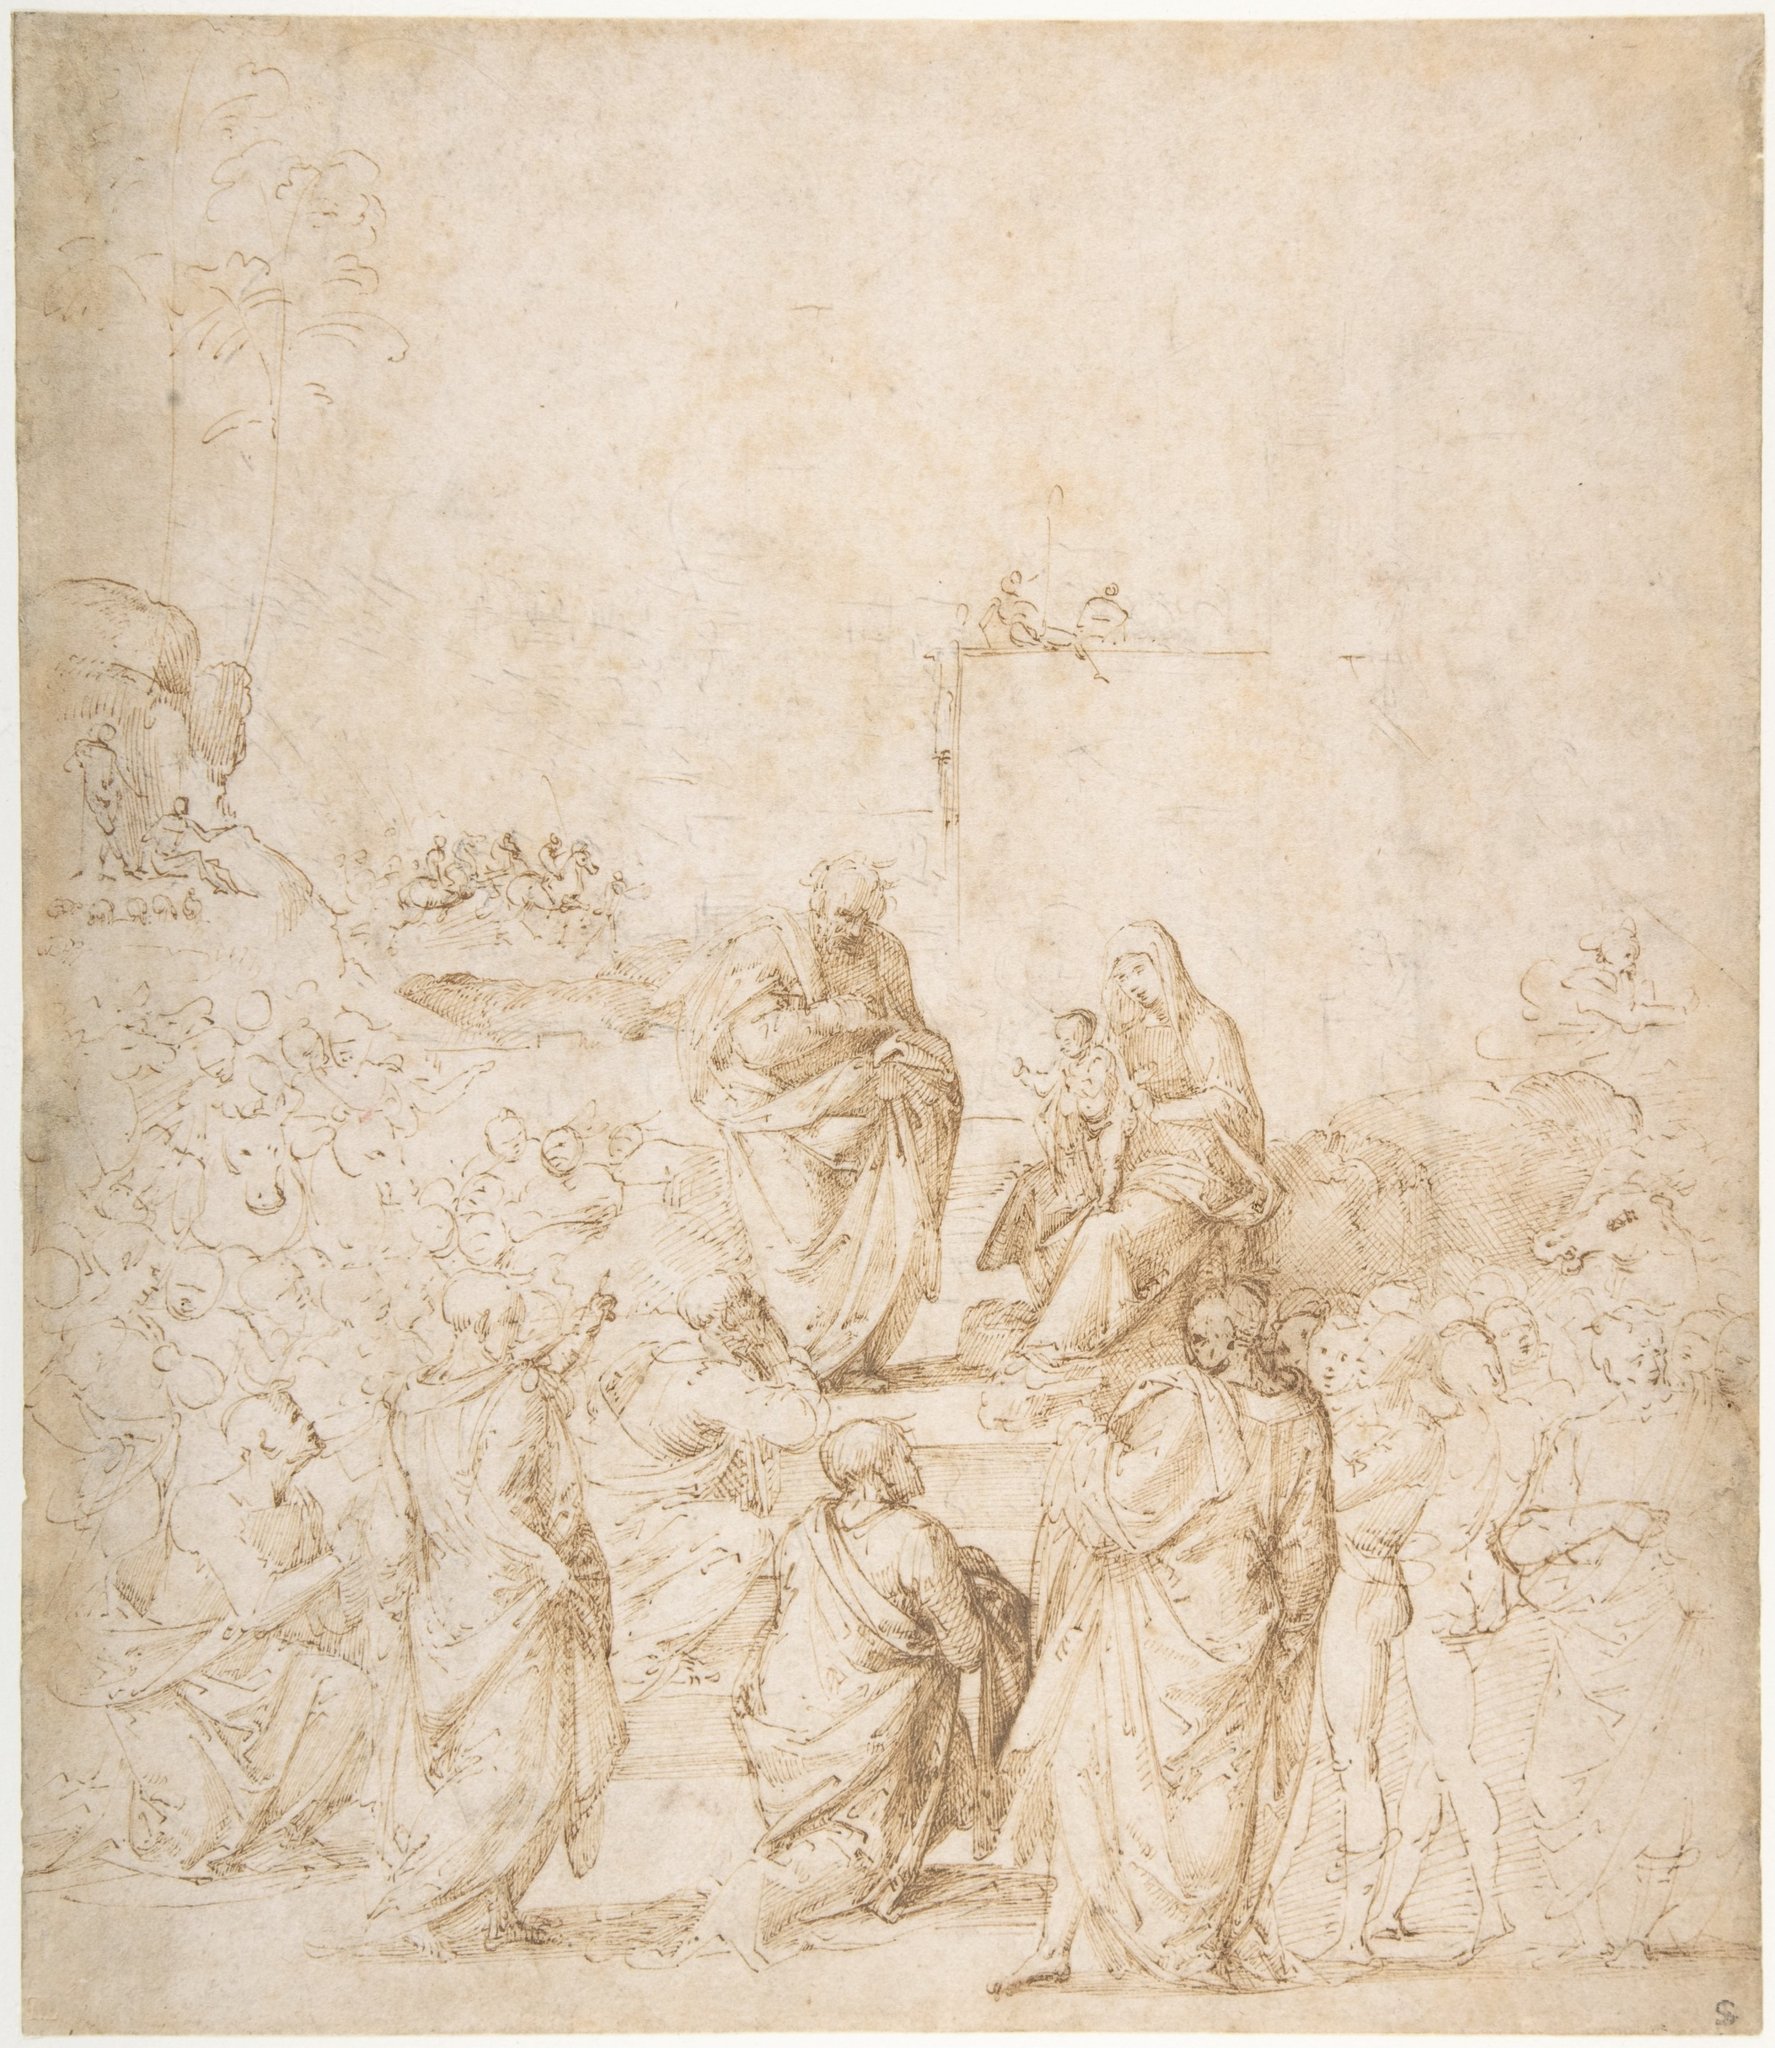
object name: drawing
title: The Adoration of the Magi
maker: fra bartolomeo (bartolomeo di paolo del fattorino)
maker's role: artist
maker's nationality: italian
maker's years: 1473-1517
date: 1500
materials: chalk, ink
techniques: pen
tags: adoration of the magi